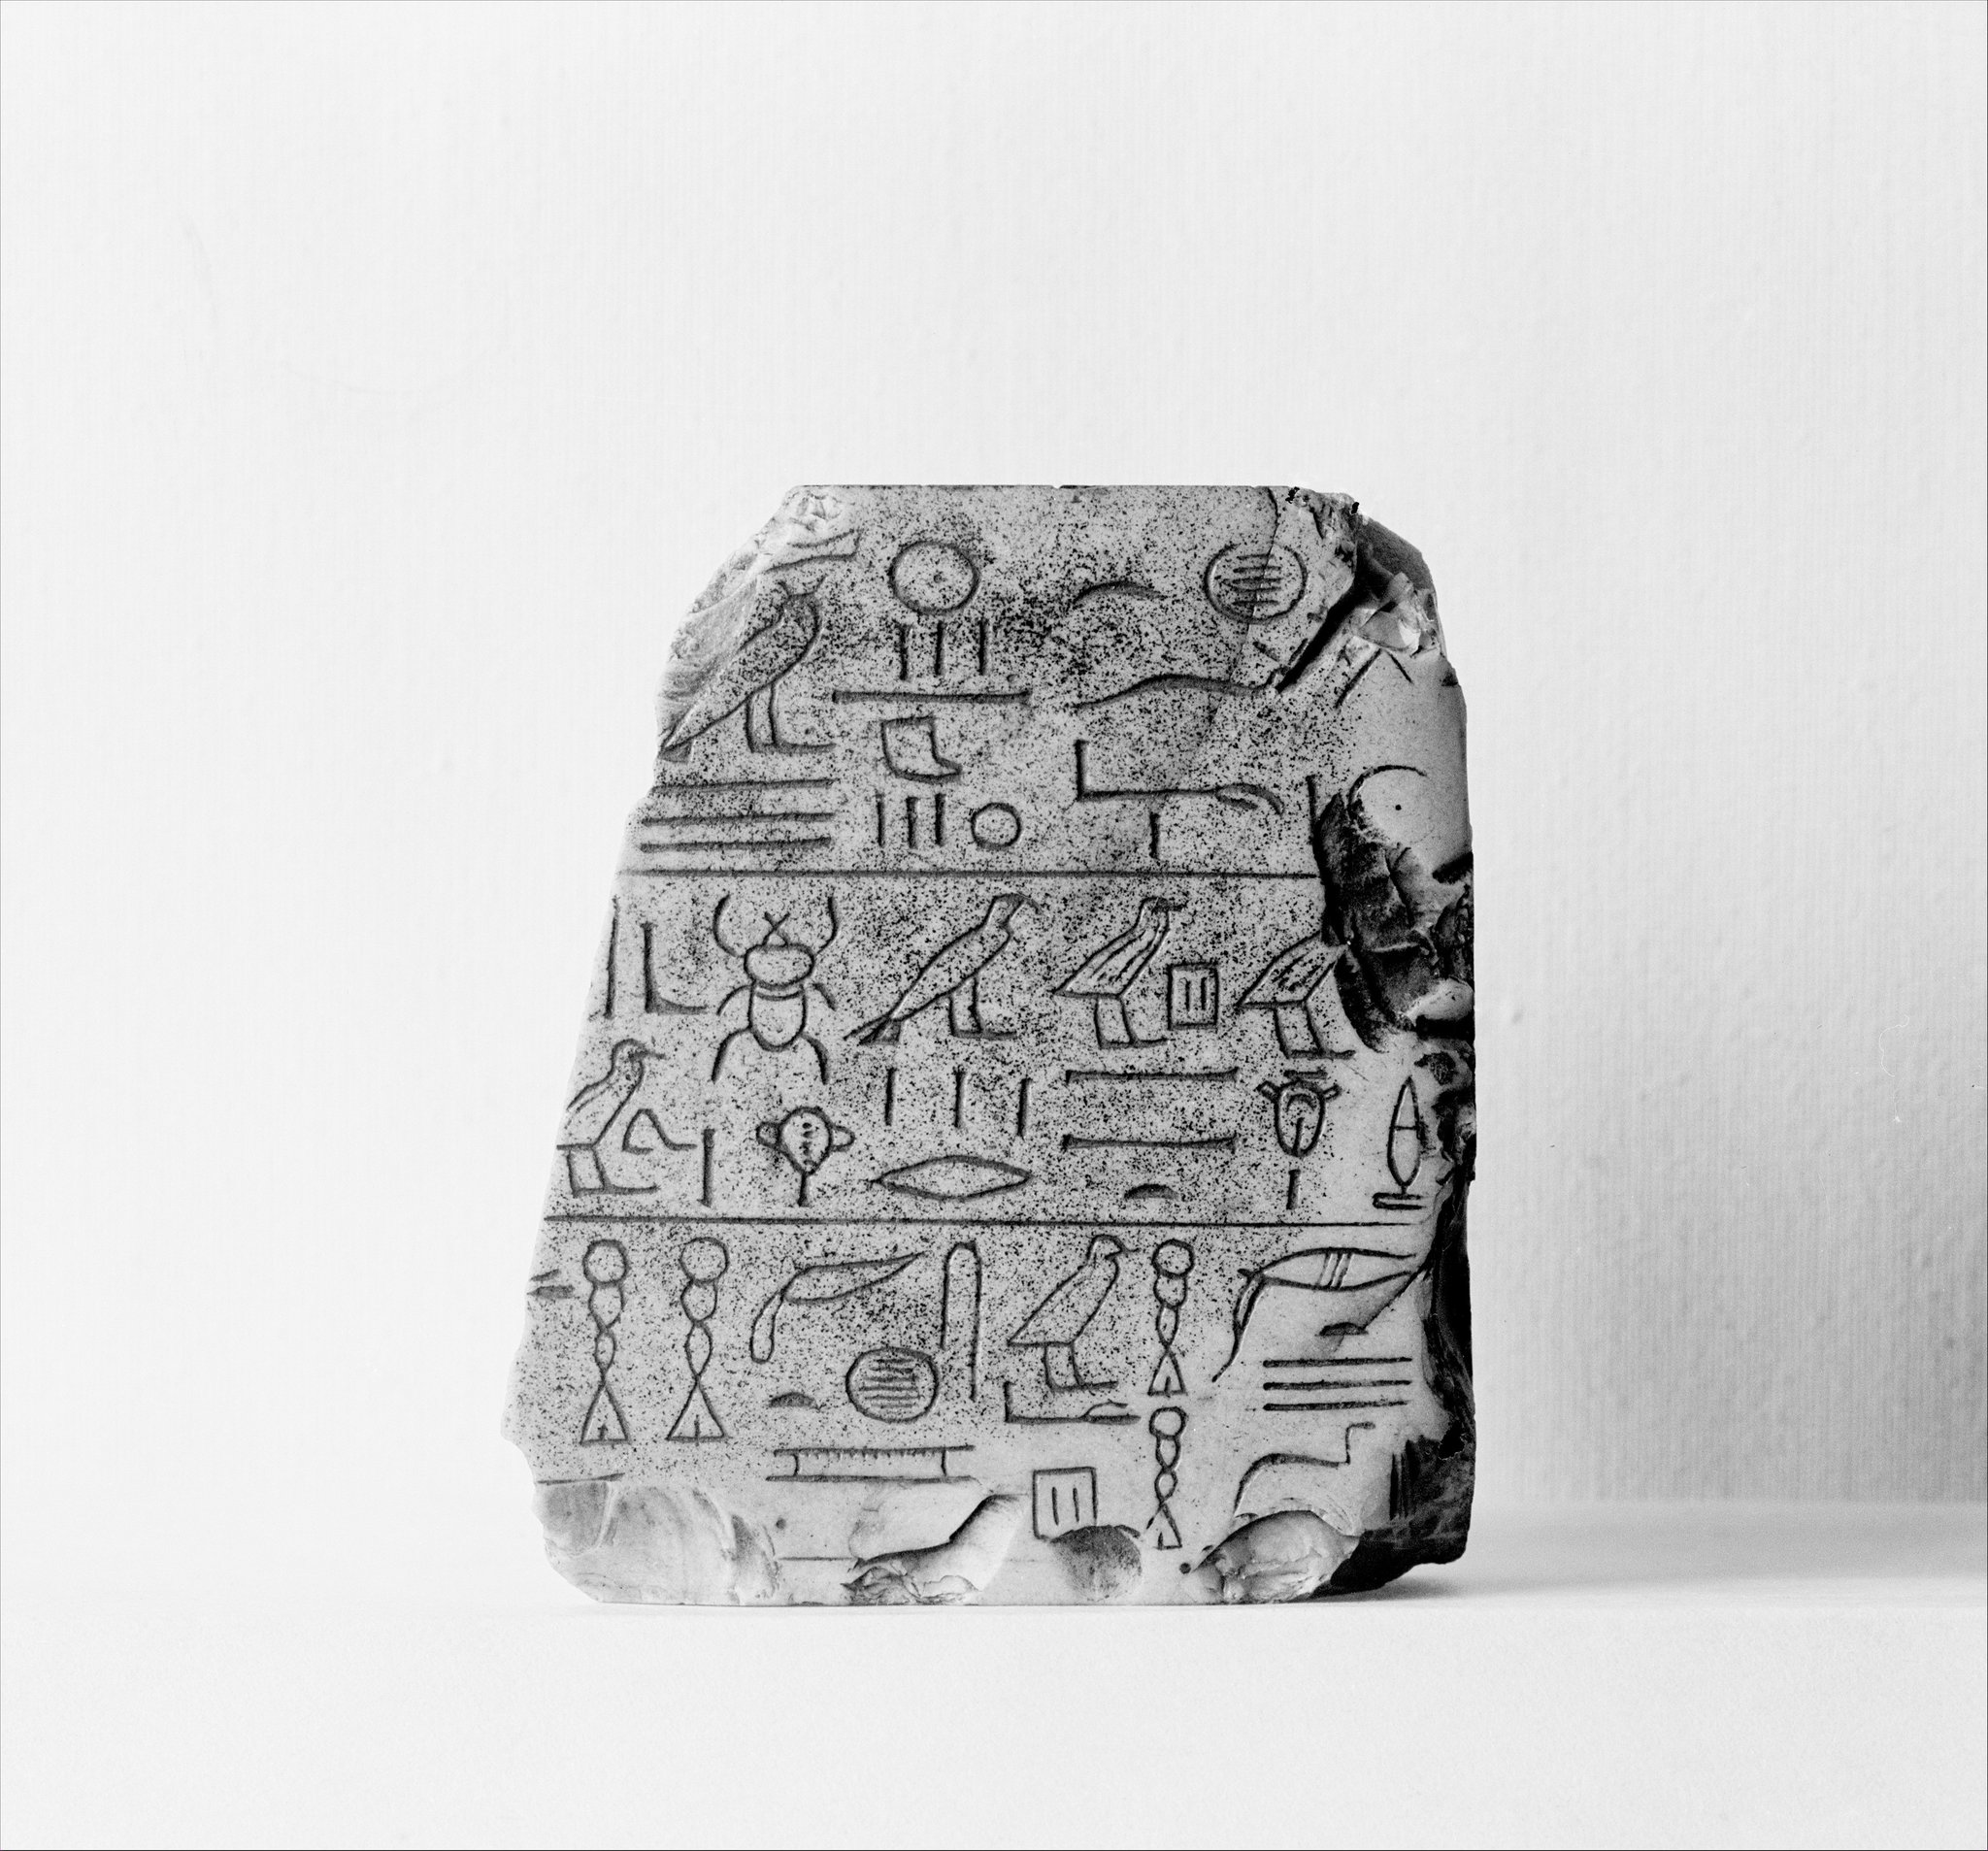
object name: measuring rod, fragment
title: Measuring rod fragment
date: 1295-1070 BCE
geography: egypt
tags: hieroglyphs